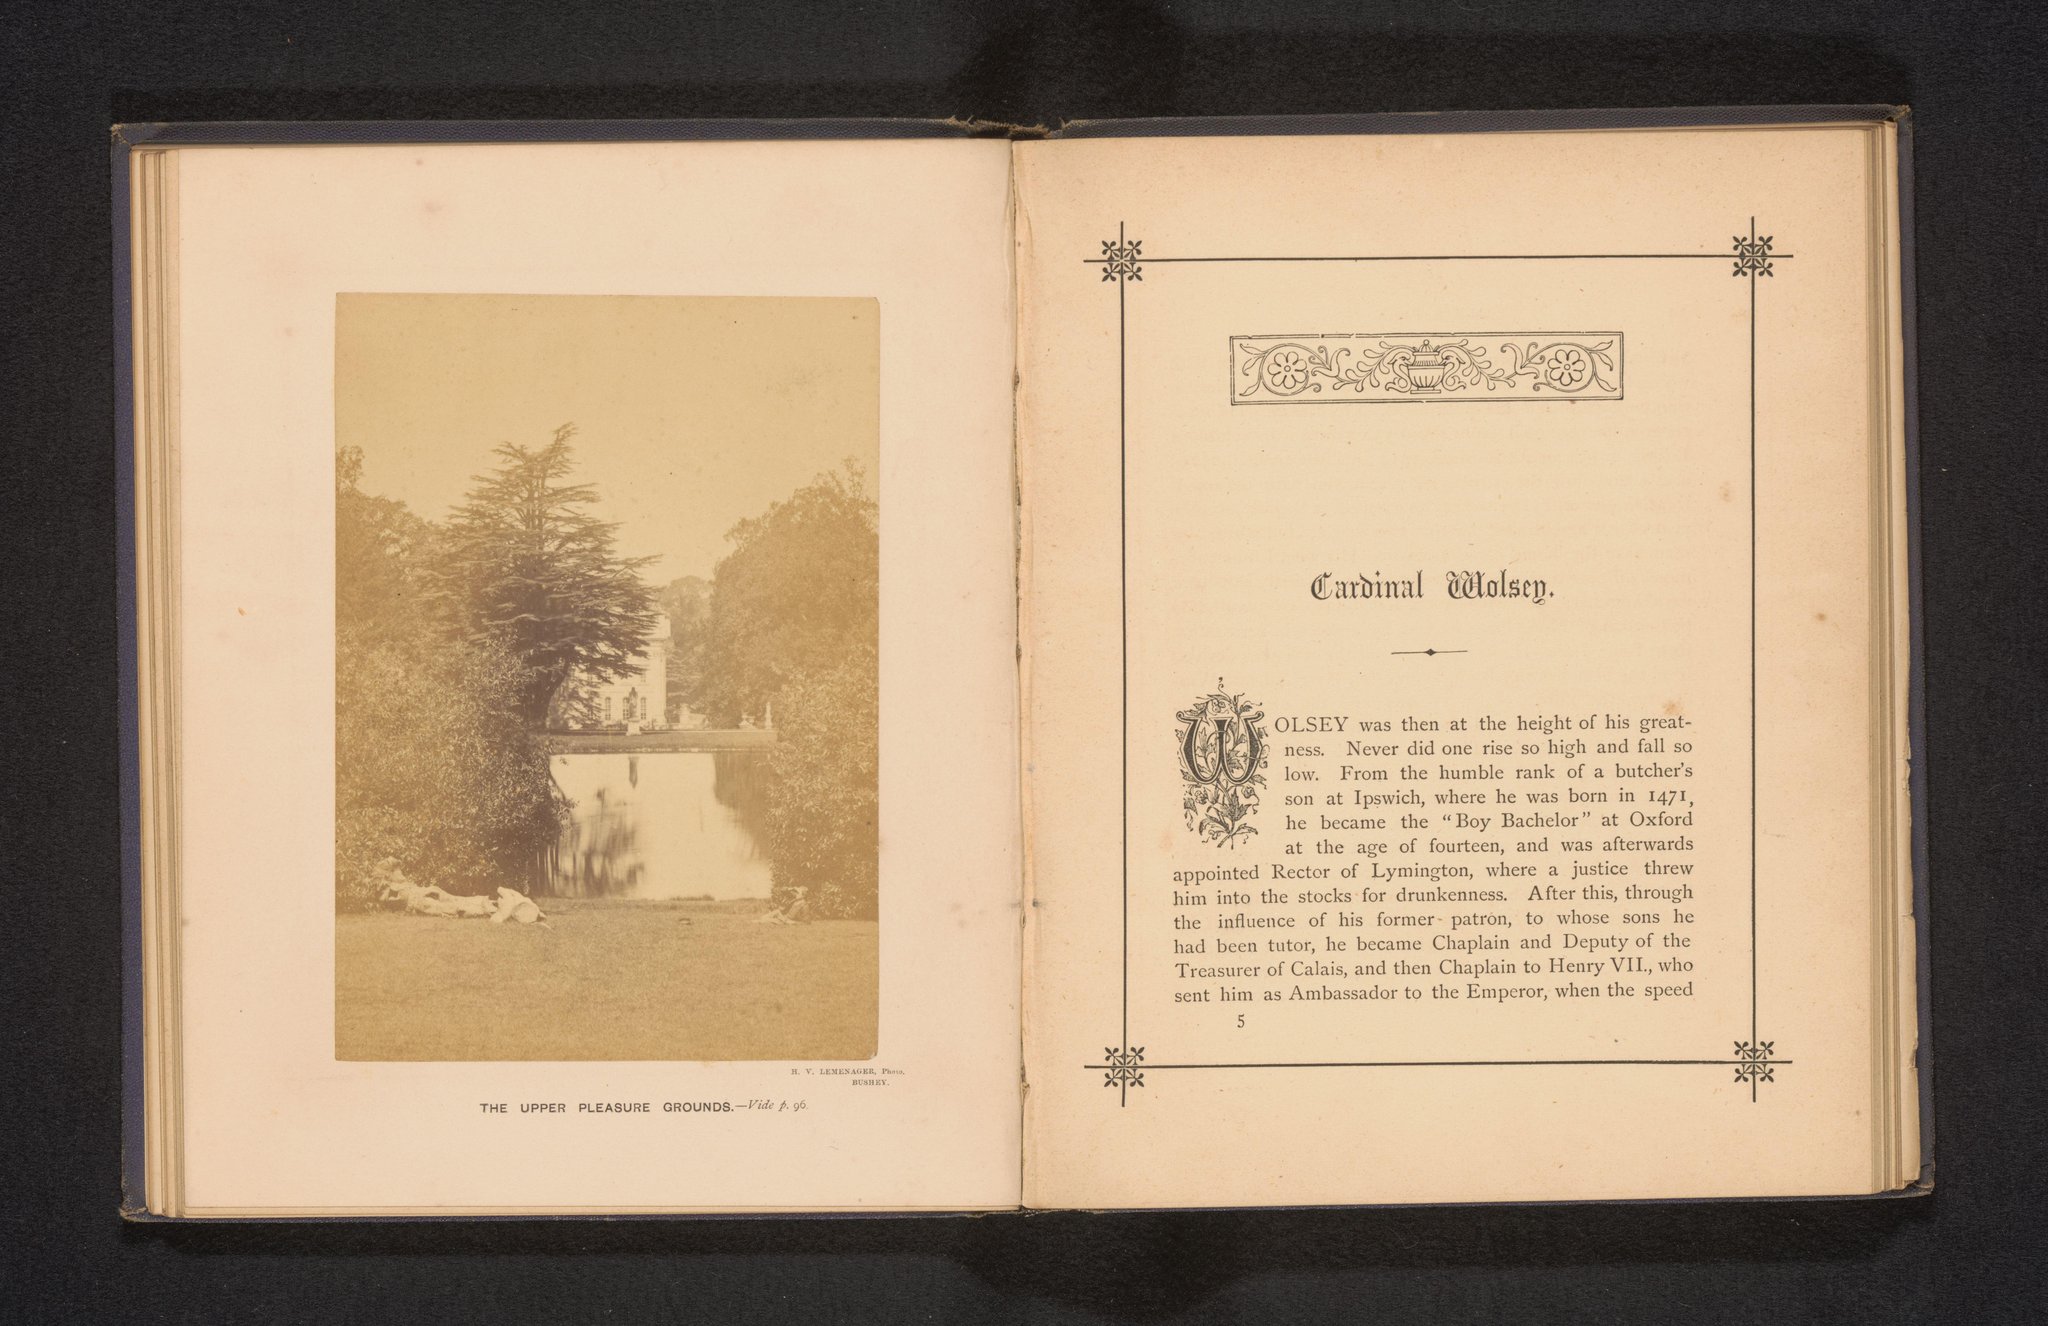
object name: page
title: The Upper Pleasure Grounds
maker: henri victor leménager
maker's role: docent, fotograaf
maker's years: 1822-1912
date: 1866-1871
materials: photographic support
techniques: albumen print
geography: rickmansworth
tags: park, garden pond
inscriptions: inscription: ‘Vide p. 96.’